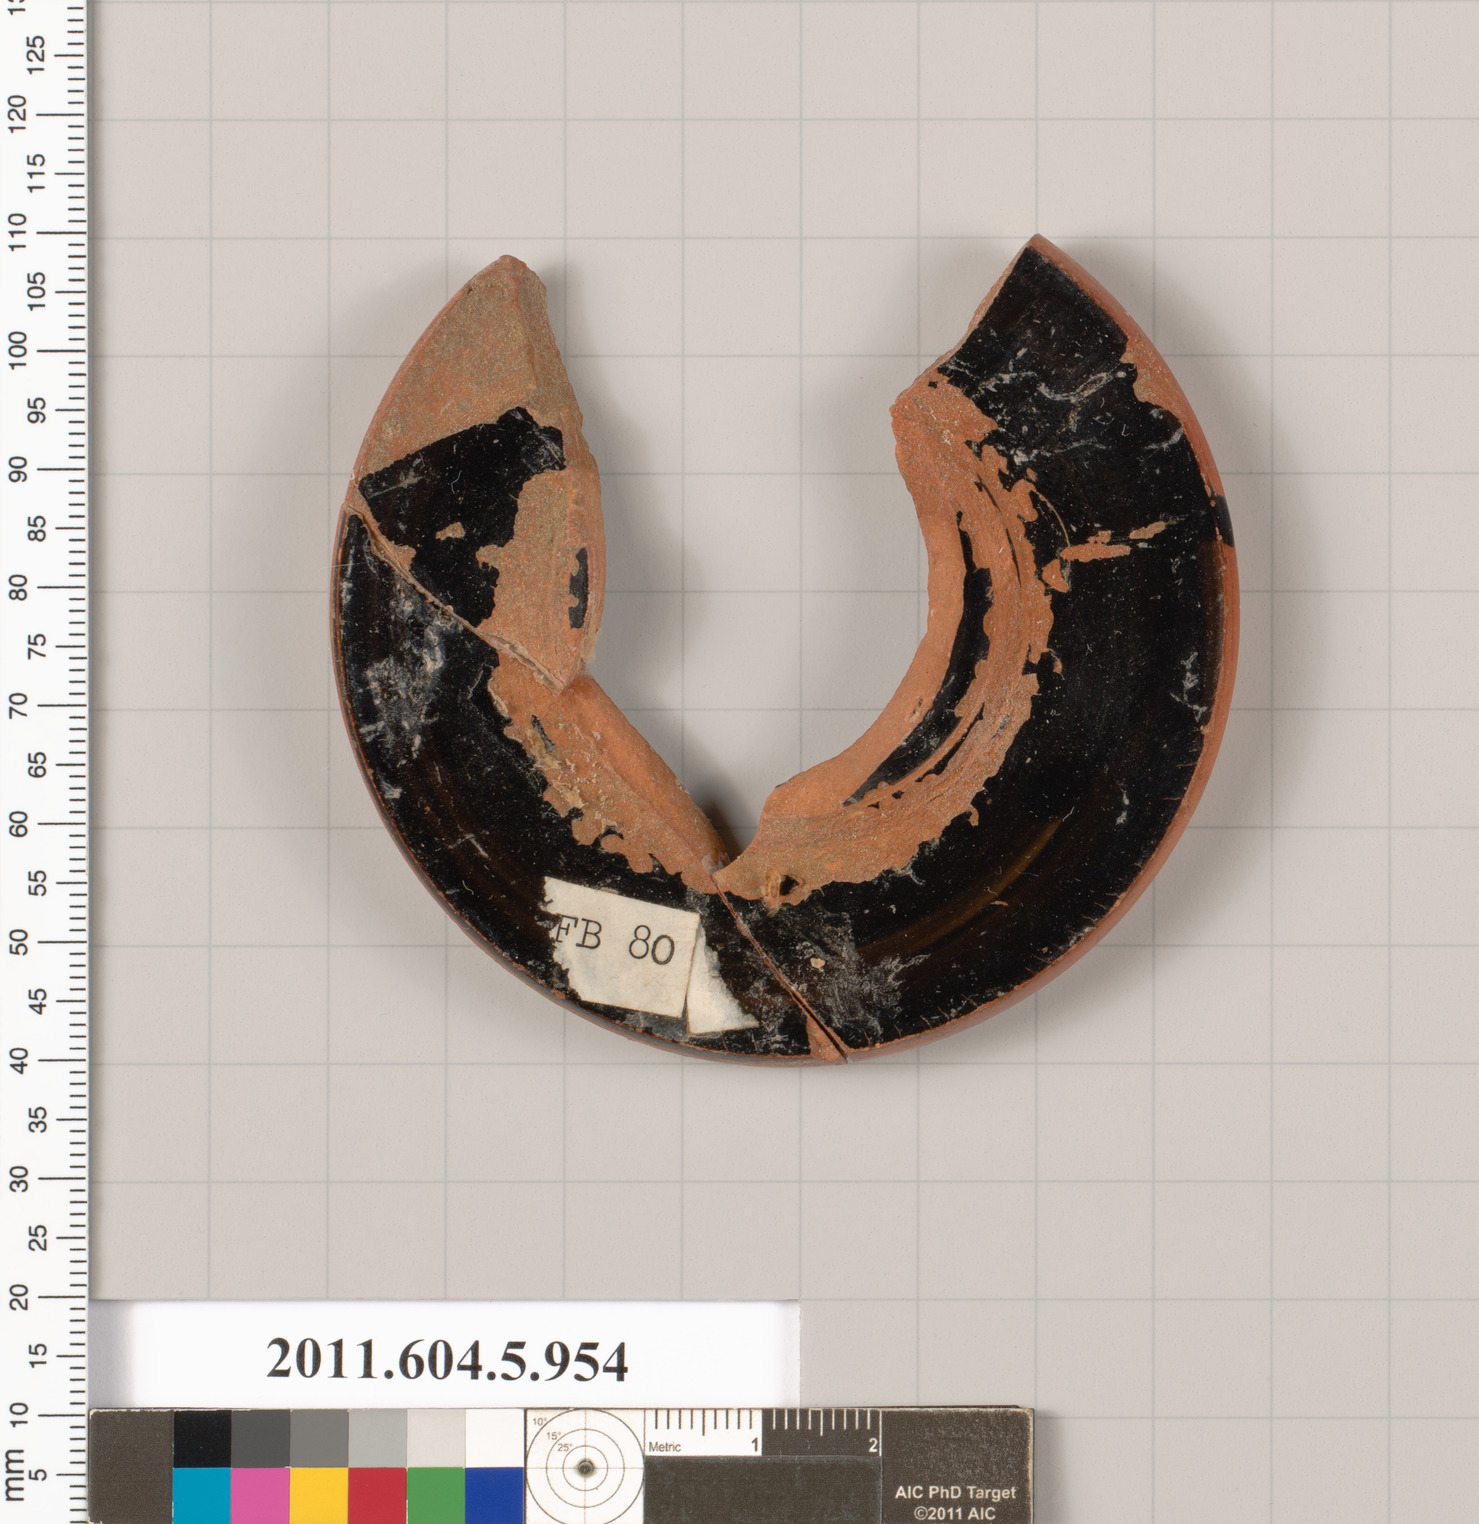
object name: kylix fragment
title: Terracotta fragment of a kylix (drinking cup)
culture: greek, attic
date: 600-401 BCE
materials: terracotta